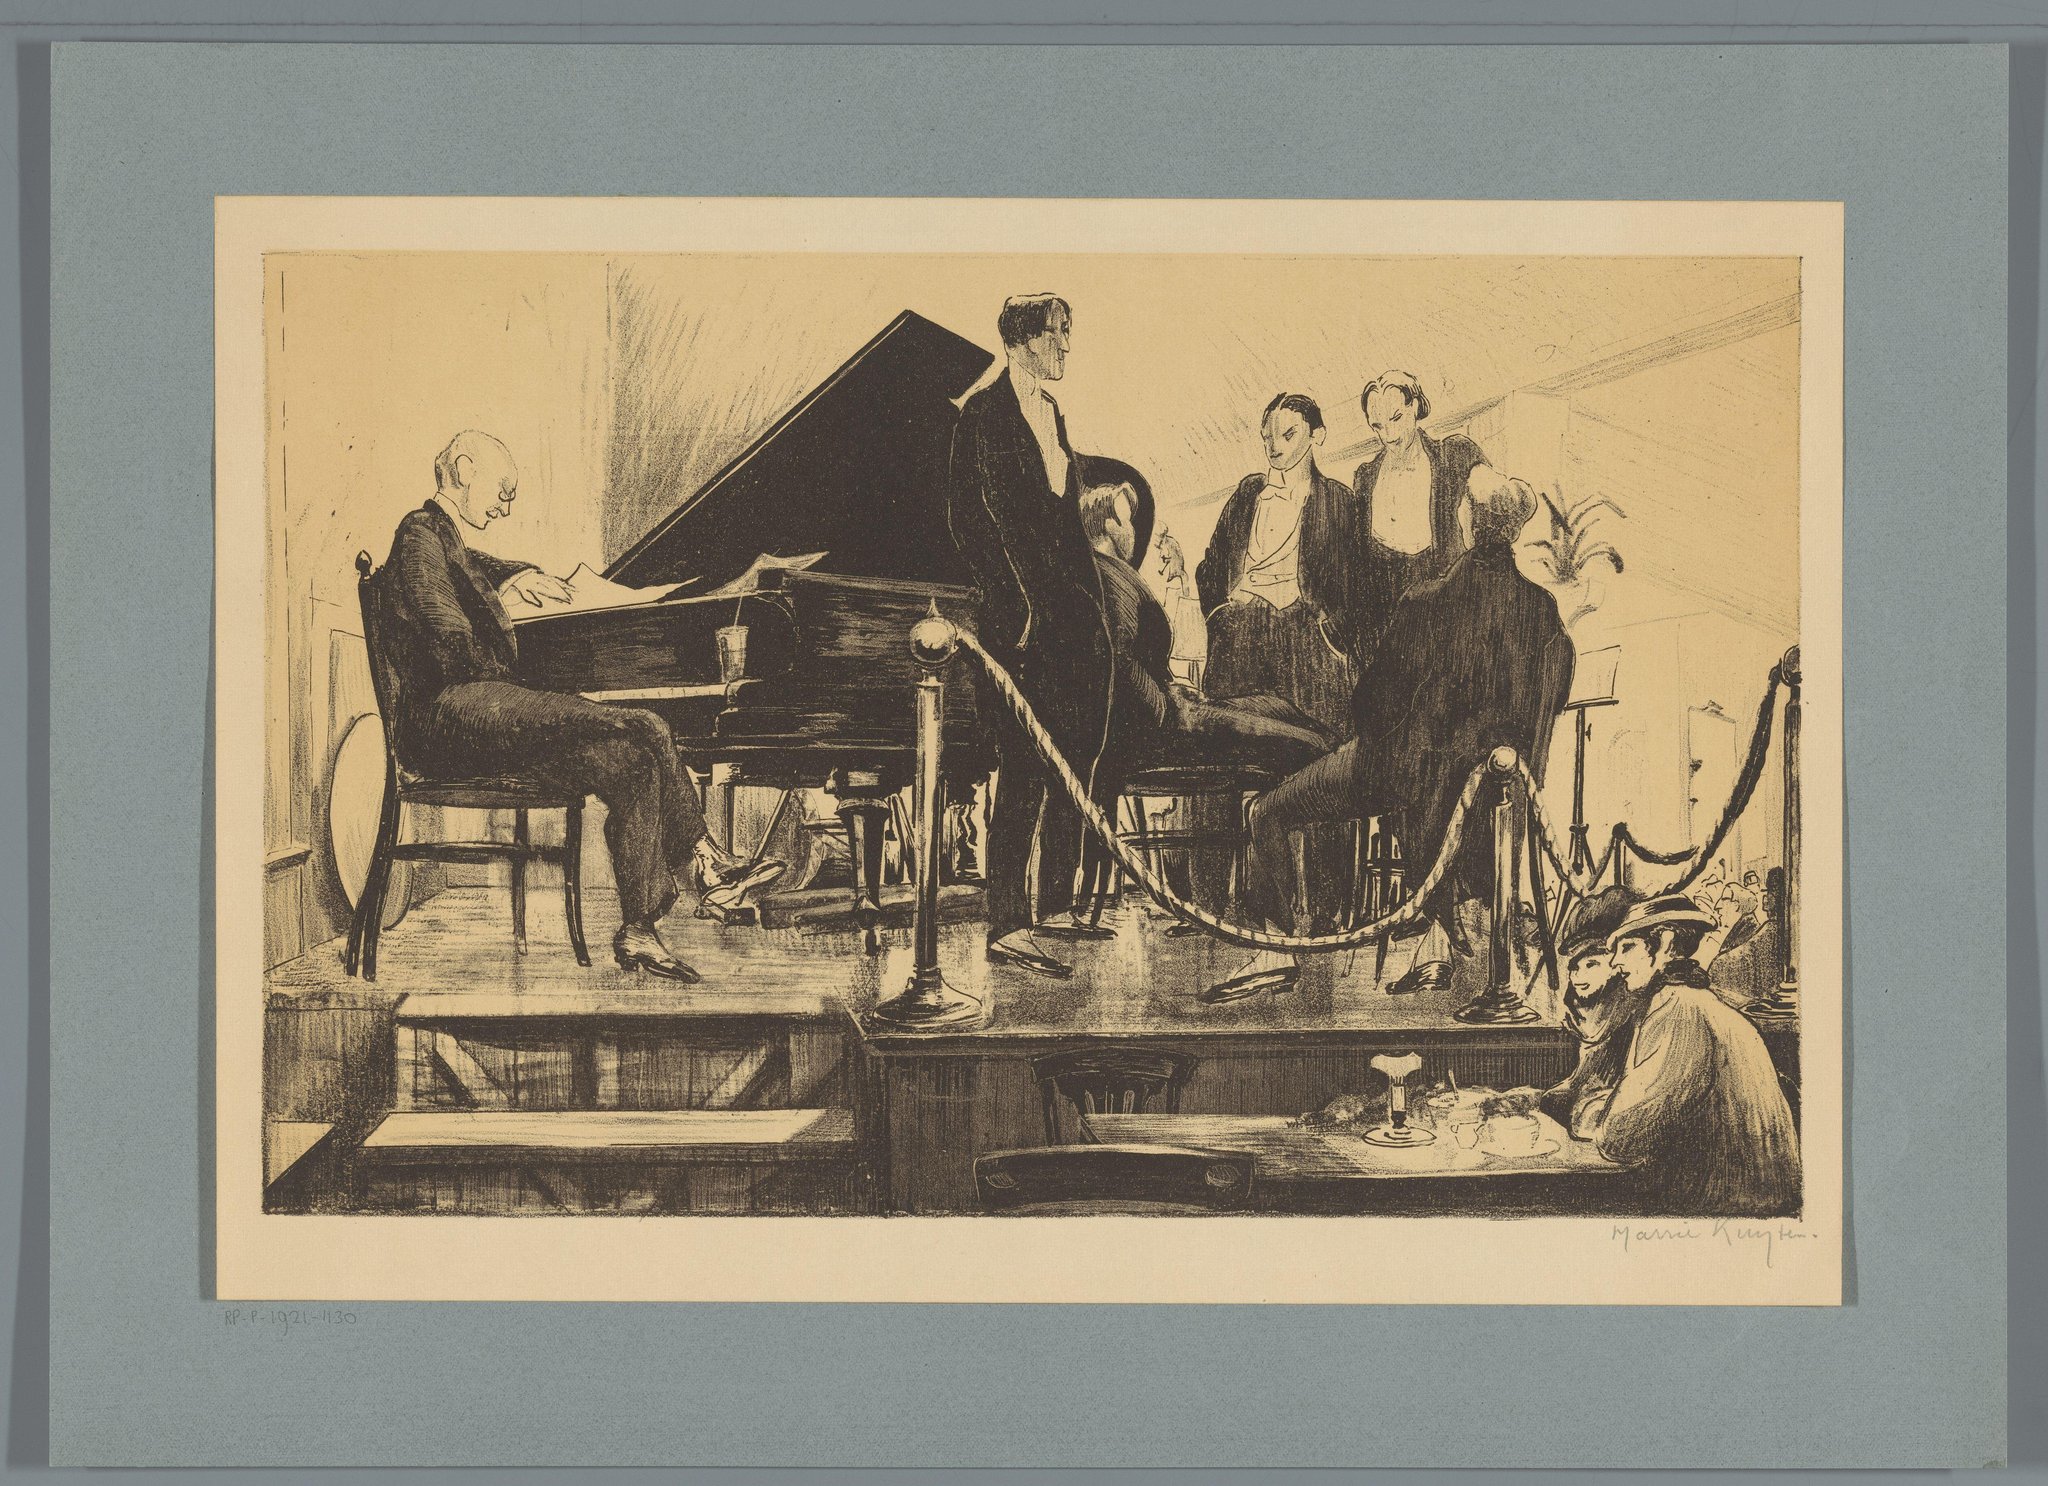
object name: print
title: Rustende muzikanten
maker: harrie kuyten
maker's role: print maker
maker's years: 1883-1952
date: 1893-1921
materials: paper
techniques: tone lithography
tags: musician, grand piano, resting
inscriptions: collector's mark: Lugt 2233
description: Een podium waarop een groep van vijf muzikanten rust. Links zit de pianist zijn partituur door te bladeren.